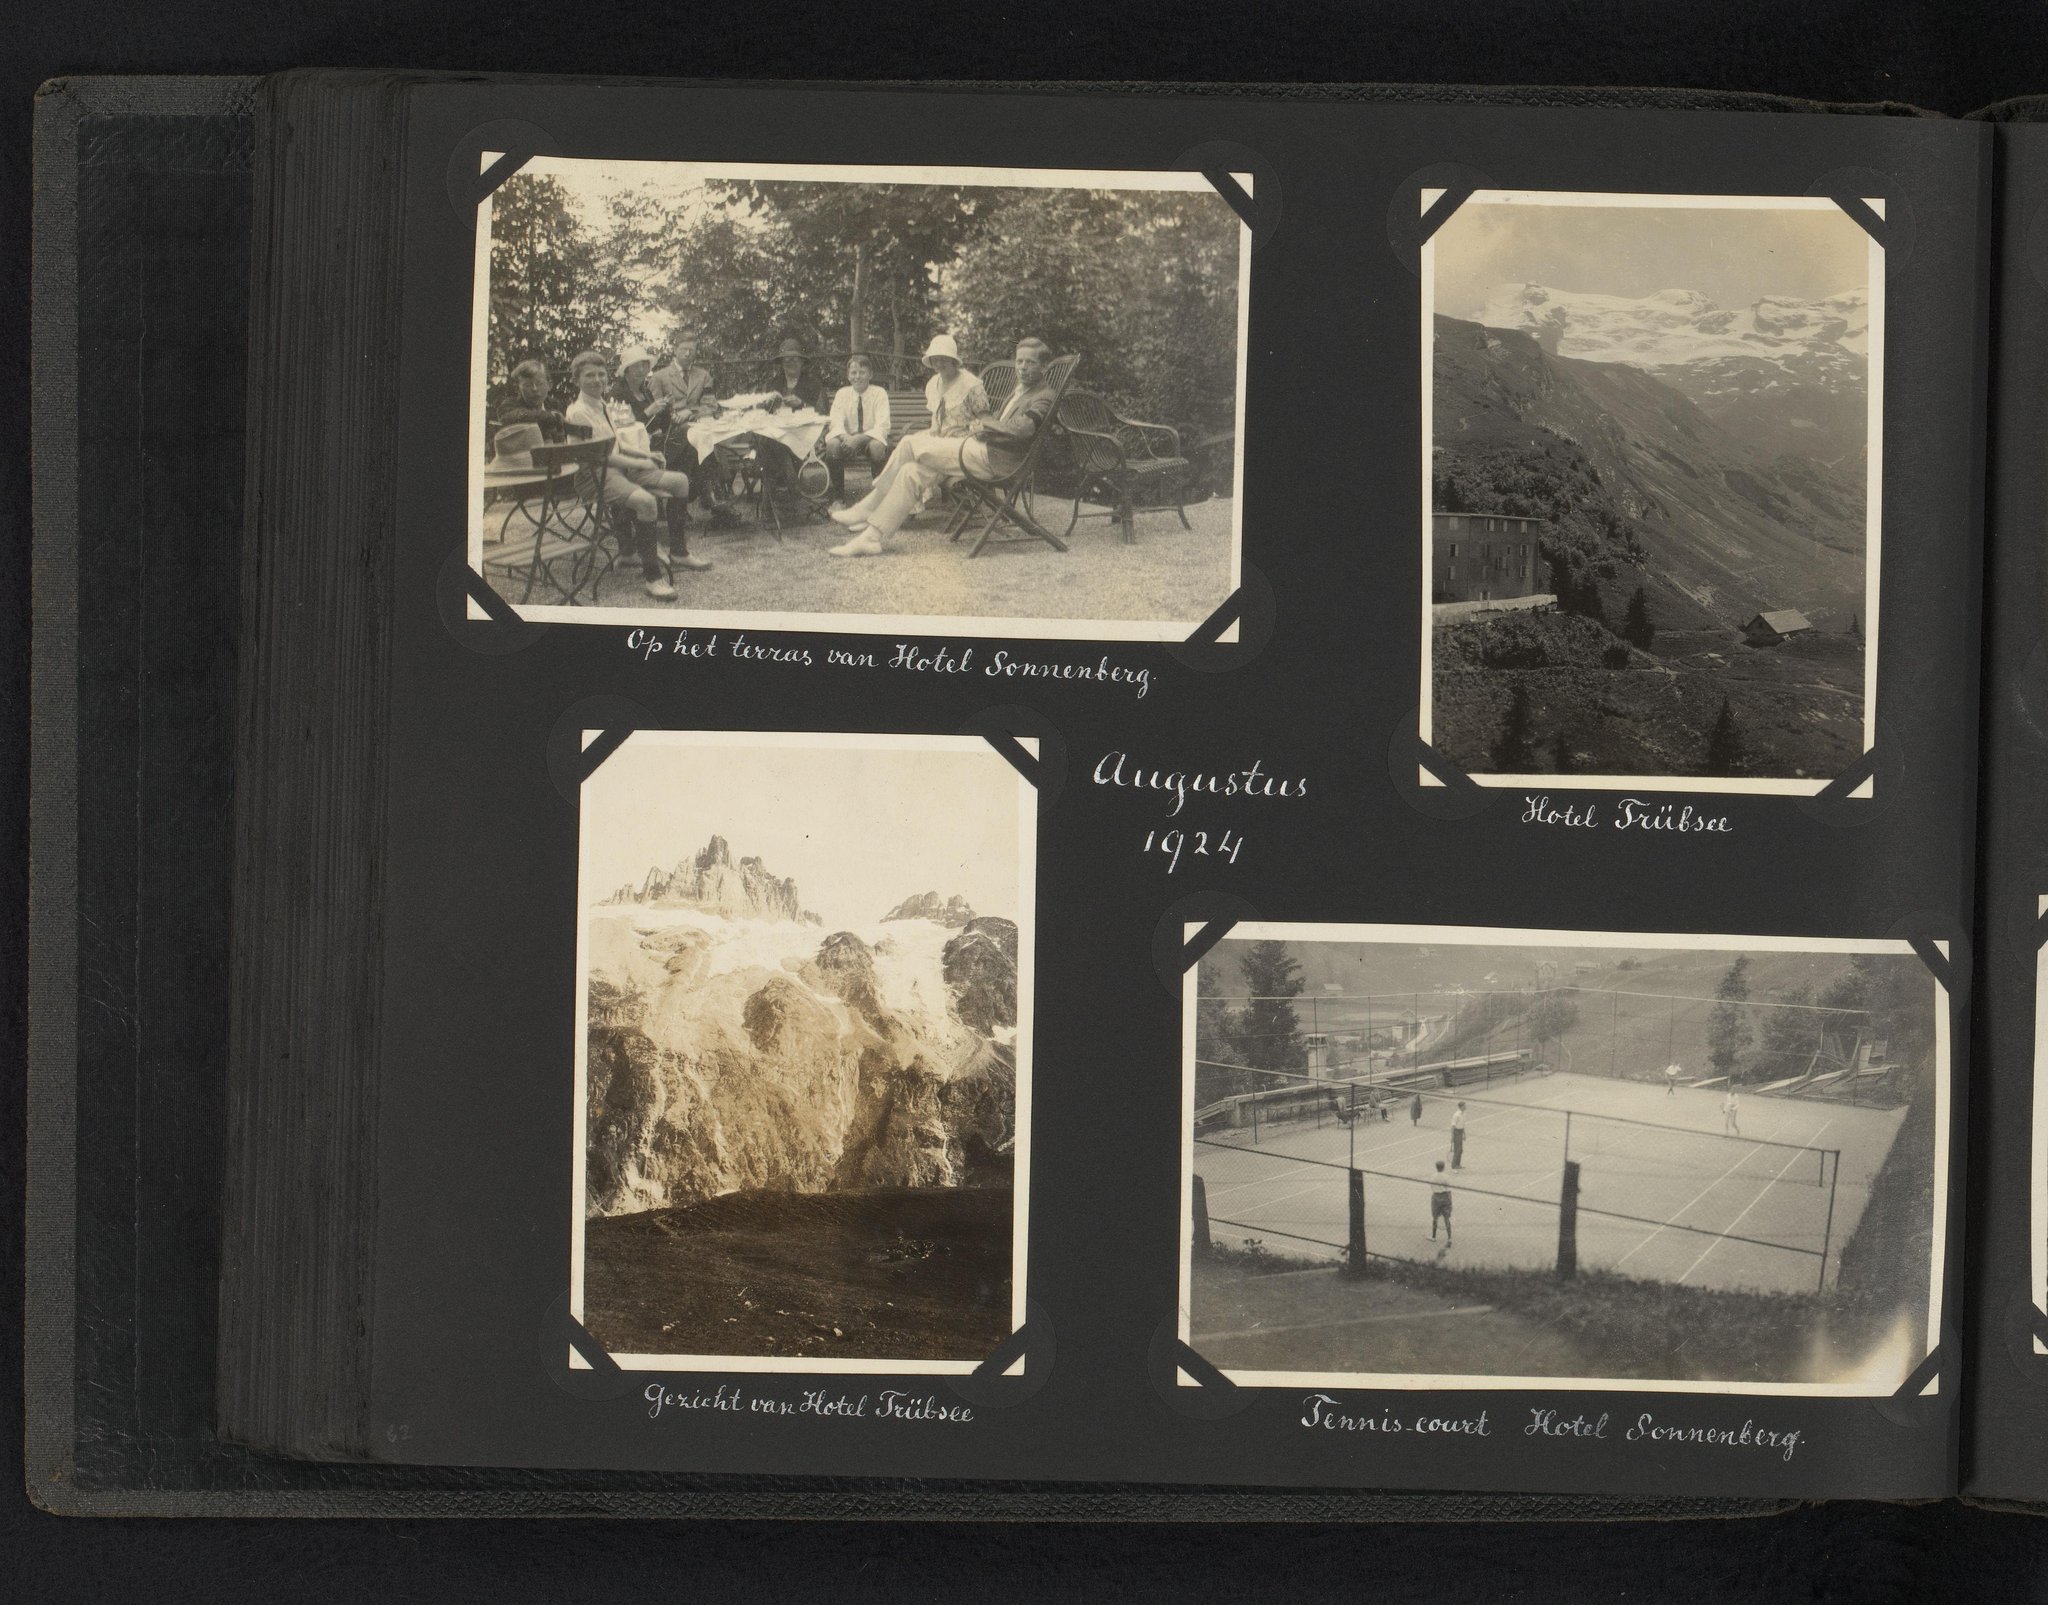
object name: photograph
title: Augustus 1924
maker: hendrik herman van den berg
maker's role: amateurfotograaf, jurist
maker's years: 1875-1944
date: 1908-1924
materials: paper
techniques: gelatin silver print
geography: switzerland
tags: the family travelling, on holiday, tennis, lawn-tennis, tourism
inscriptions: inscription: ‘Op het terras van Hotel Sonnenberg’, inscription: ‘Tennis-court Hotel Sonnenberg’, inscription: ‘Gezicht van Hotel Trübsee’, inscription: ‘Hotel Trübsee’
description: Deze foto's maken deel uit van een album.